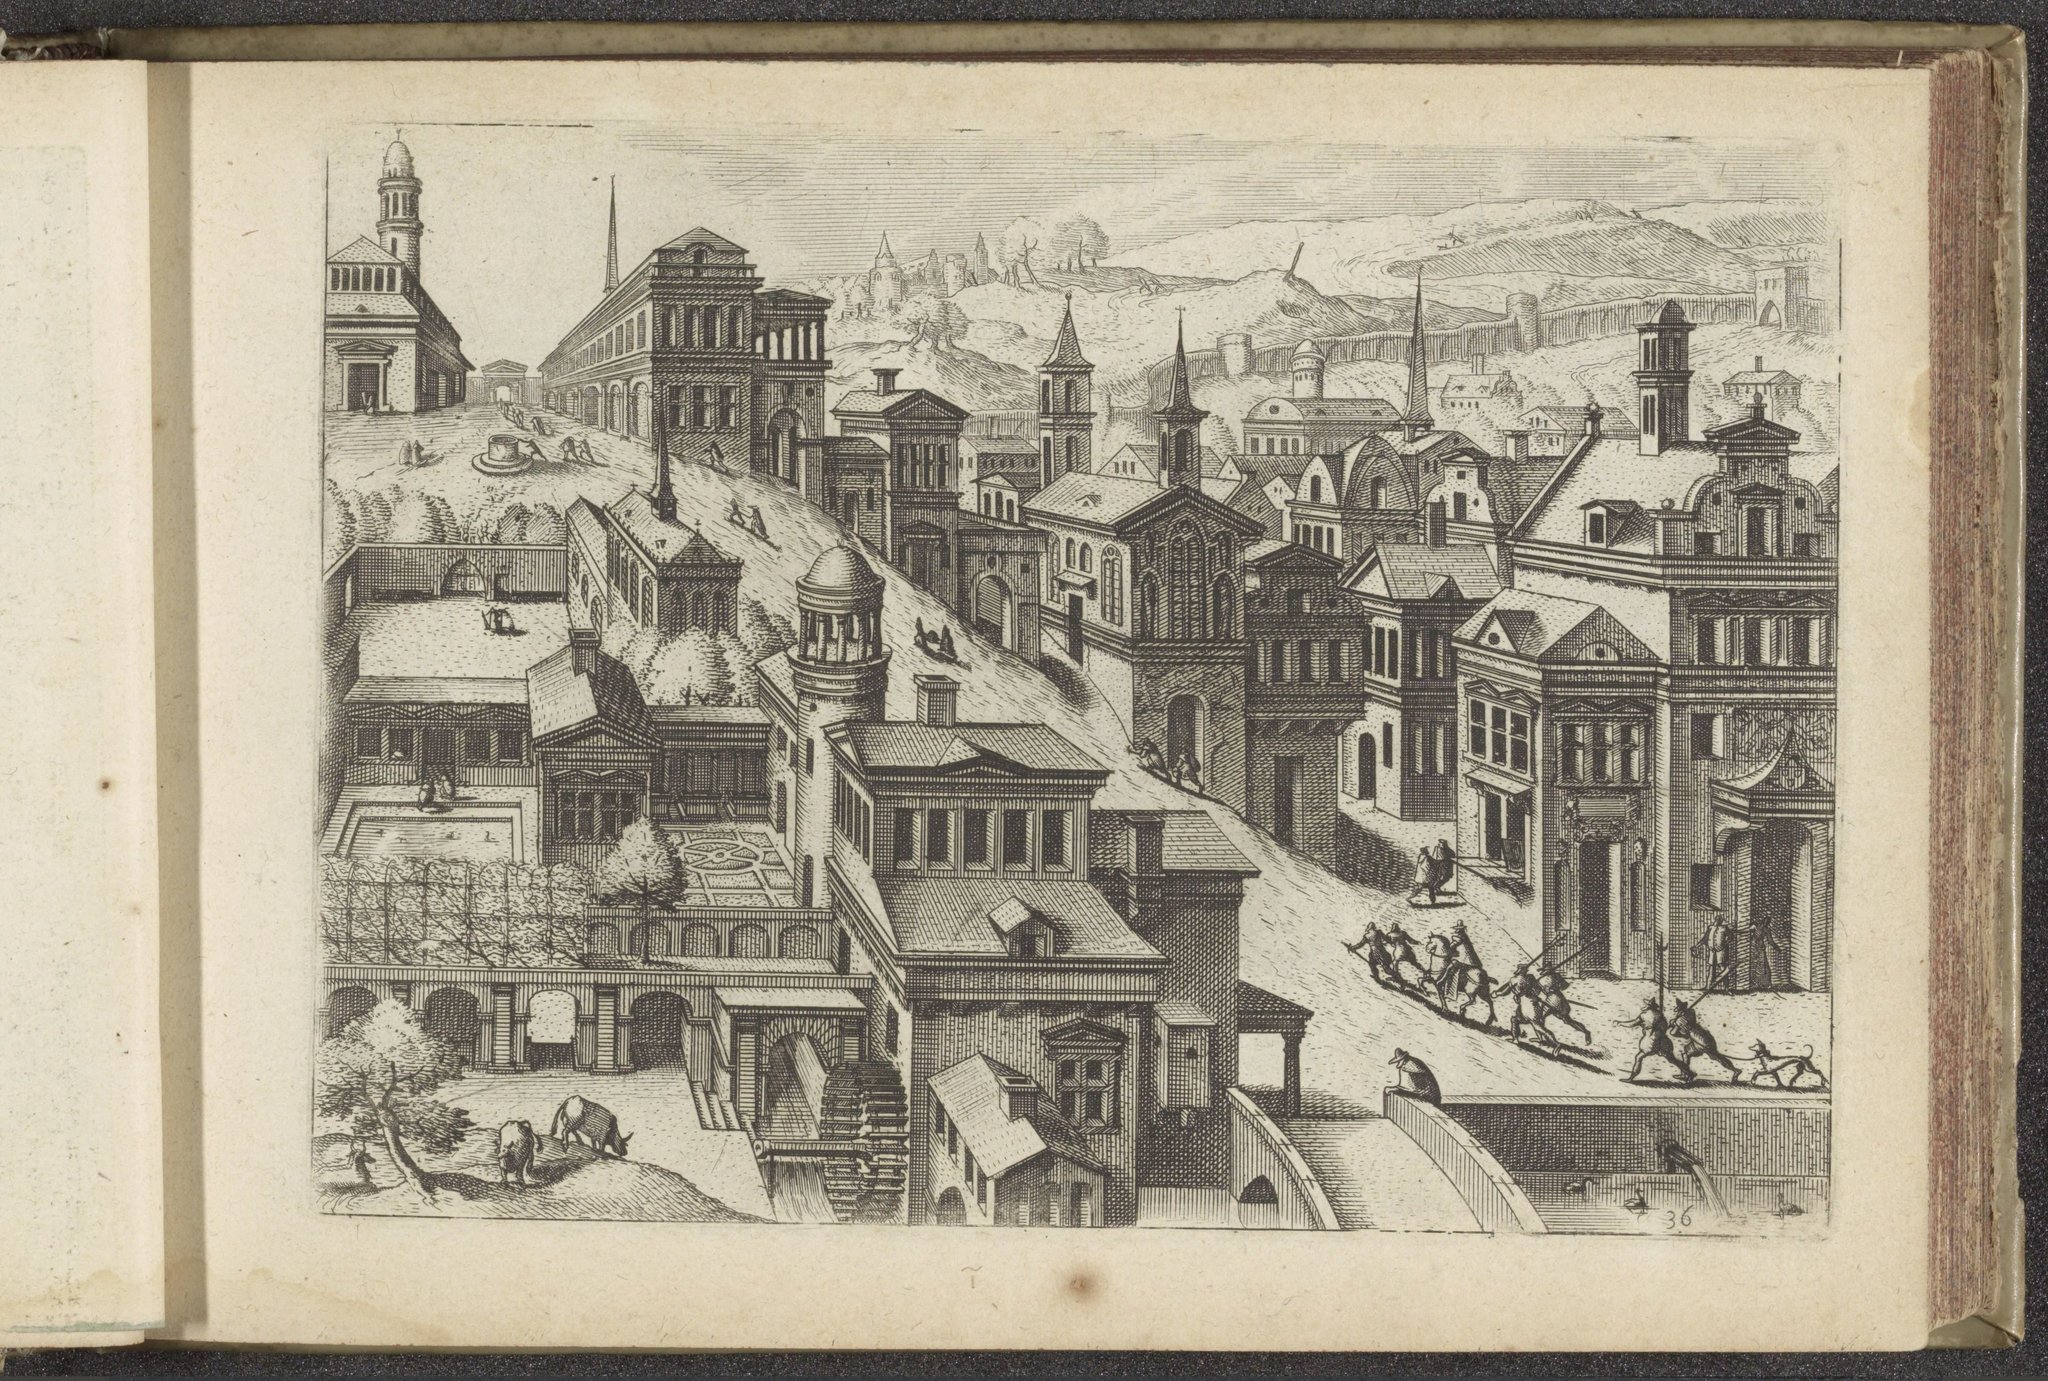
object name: album leaf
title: Gezicht op een stad in vogelvluchtperspectief met een straat die bergopwaarts gaat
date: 1562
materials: paper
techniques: etching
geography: antwerp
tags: architectural representations in general, city-view in general; 'veduta', bird's eye view ~ ideal or visionary architectural design or model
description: Gezicht op een stad in vogelvluchtperspectief met een straat die bergopwaarts gaat van rechtsonder naar linksboven. Deze prent maakt deel uit van een album.